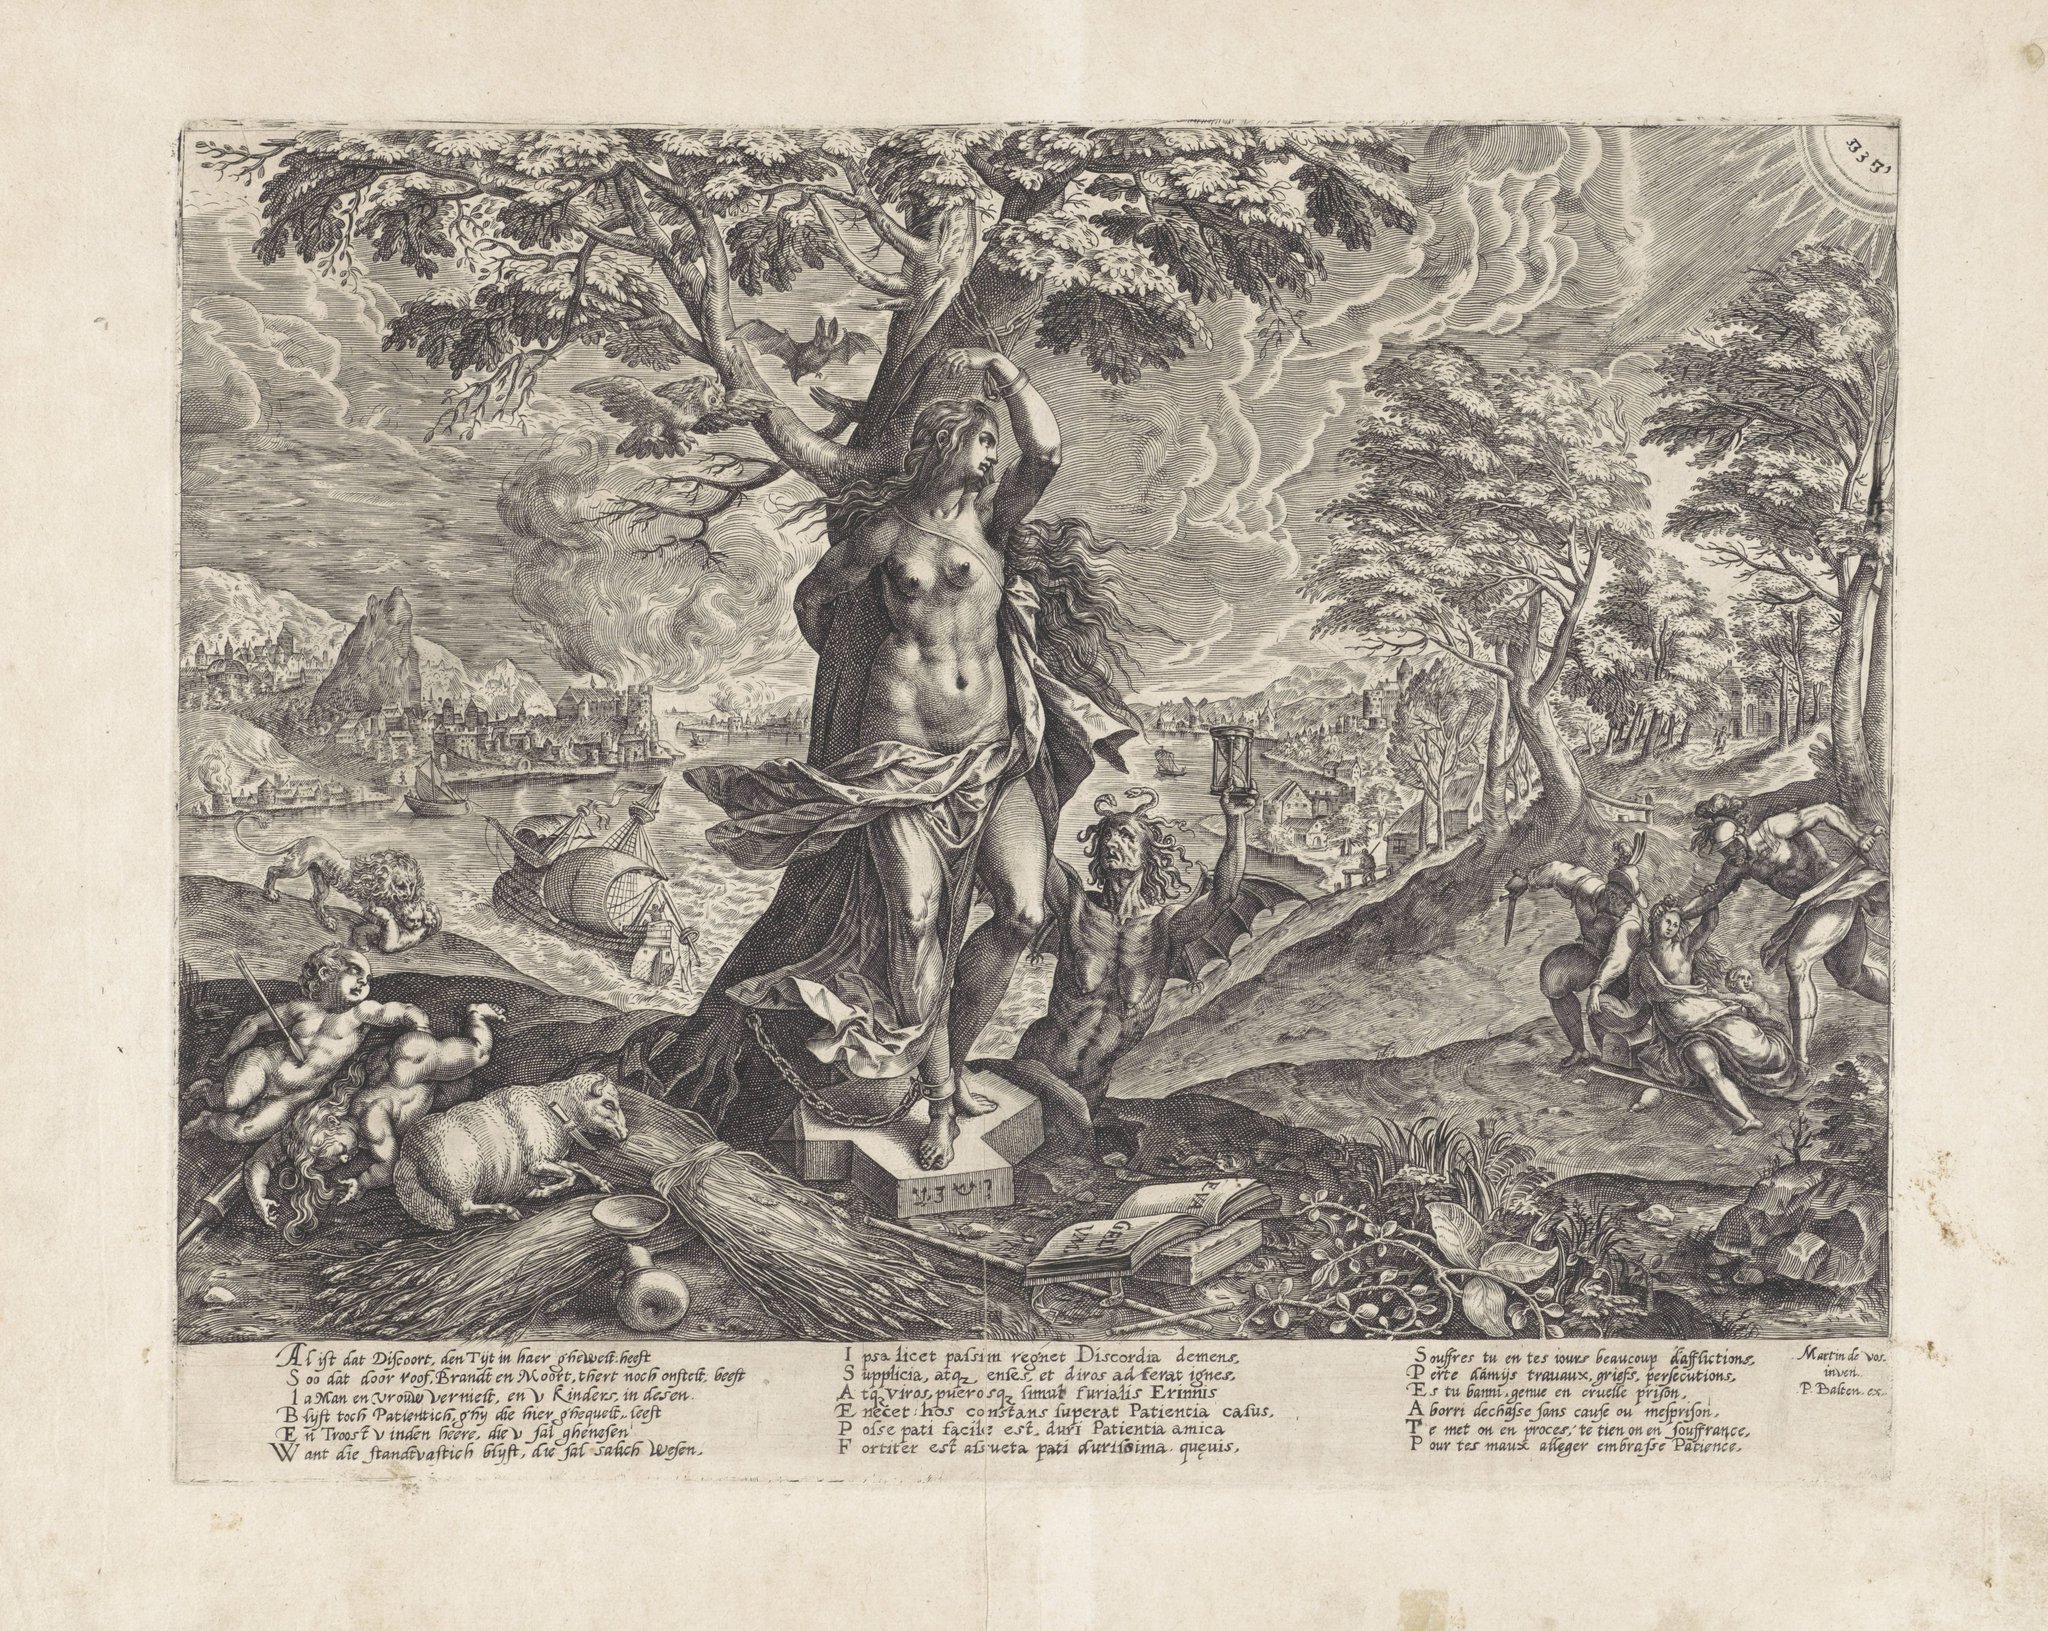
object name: propagandaprent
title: Allegorie op het geduld tijdens de periode van oorlog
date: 1577-1578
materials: paper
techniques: engraving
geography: antwerp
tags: flying mammals: bat, patience; 'patienza' (ripa), allegorical representations of the effects of time, disagreement, discord; 'discordia' (ripa), owls, horrors of war, tetragram (in roman or hebrew script) ~ symbol of god the father, the bible as a book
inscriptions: collector's mark: Lugt 2760, address: ‘P.Baltens ex.’, signature: ‘Marten de Vos inven.’, collector's mark: Lugt 2228, caption: ‘Al ist dat Discoort, den Tijt in haer gewelt heeft...Want die standvastich blijft, die sal salich wesen’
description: Politieke allegorie op het geduld in de tijd van de Tachtigjarige Oorlog, ca. 1577. De vrouwelijke personificatie van Geduld (Patientia), weergegeven als een naakte vrouw, is geketend aan een boom. Naast haar hoofd vliegen een uil en een vleermuis. Voor haar op de grond ligt het geopende evangelie, als verwijzing naar de troost die ze vindt in het geloof. De personificatie van de Tweedracht (Discordia) ligt aan haar voeten, ze heeft de tijd aan haar zijde (gesymboliseerd door de zandloper in haar handen). Rondom scènes van moord en beroving. Rechts wordt een vrouw met kind door twee soldaten aangevallen. Links twee dode kinderen en een lam, een derde kind wordt aangevallen door een leeuw. Op de achtergrond, aan de andere oever van de rivier, een brandende stad. Rechtsboven aan de hemel het tetragram als symbool van God de Vader. In de marge een zesregelig gedicht in het Nederlands, het Latijn en het Frans.